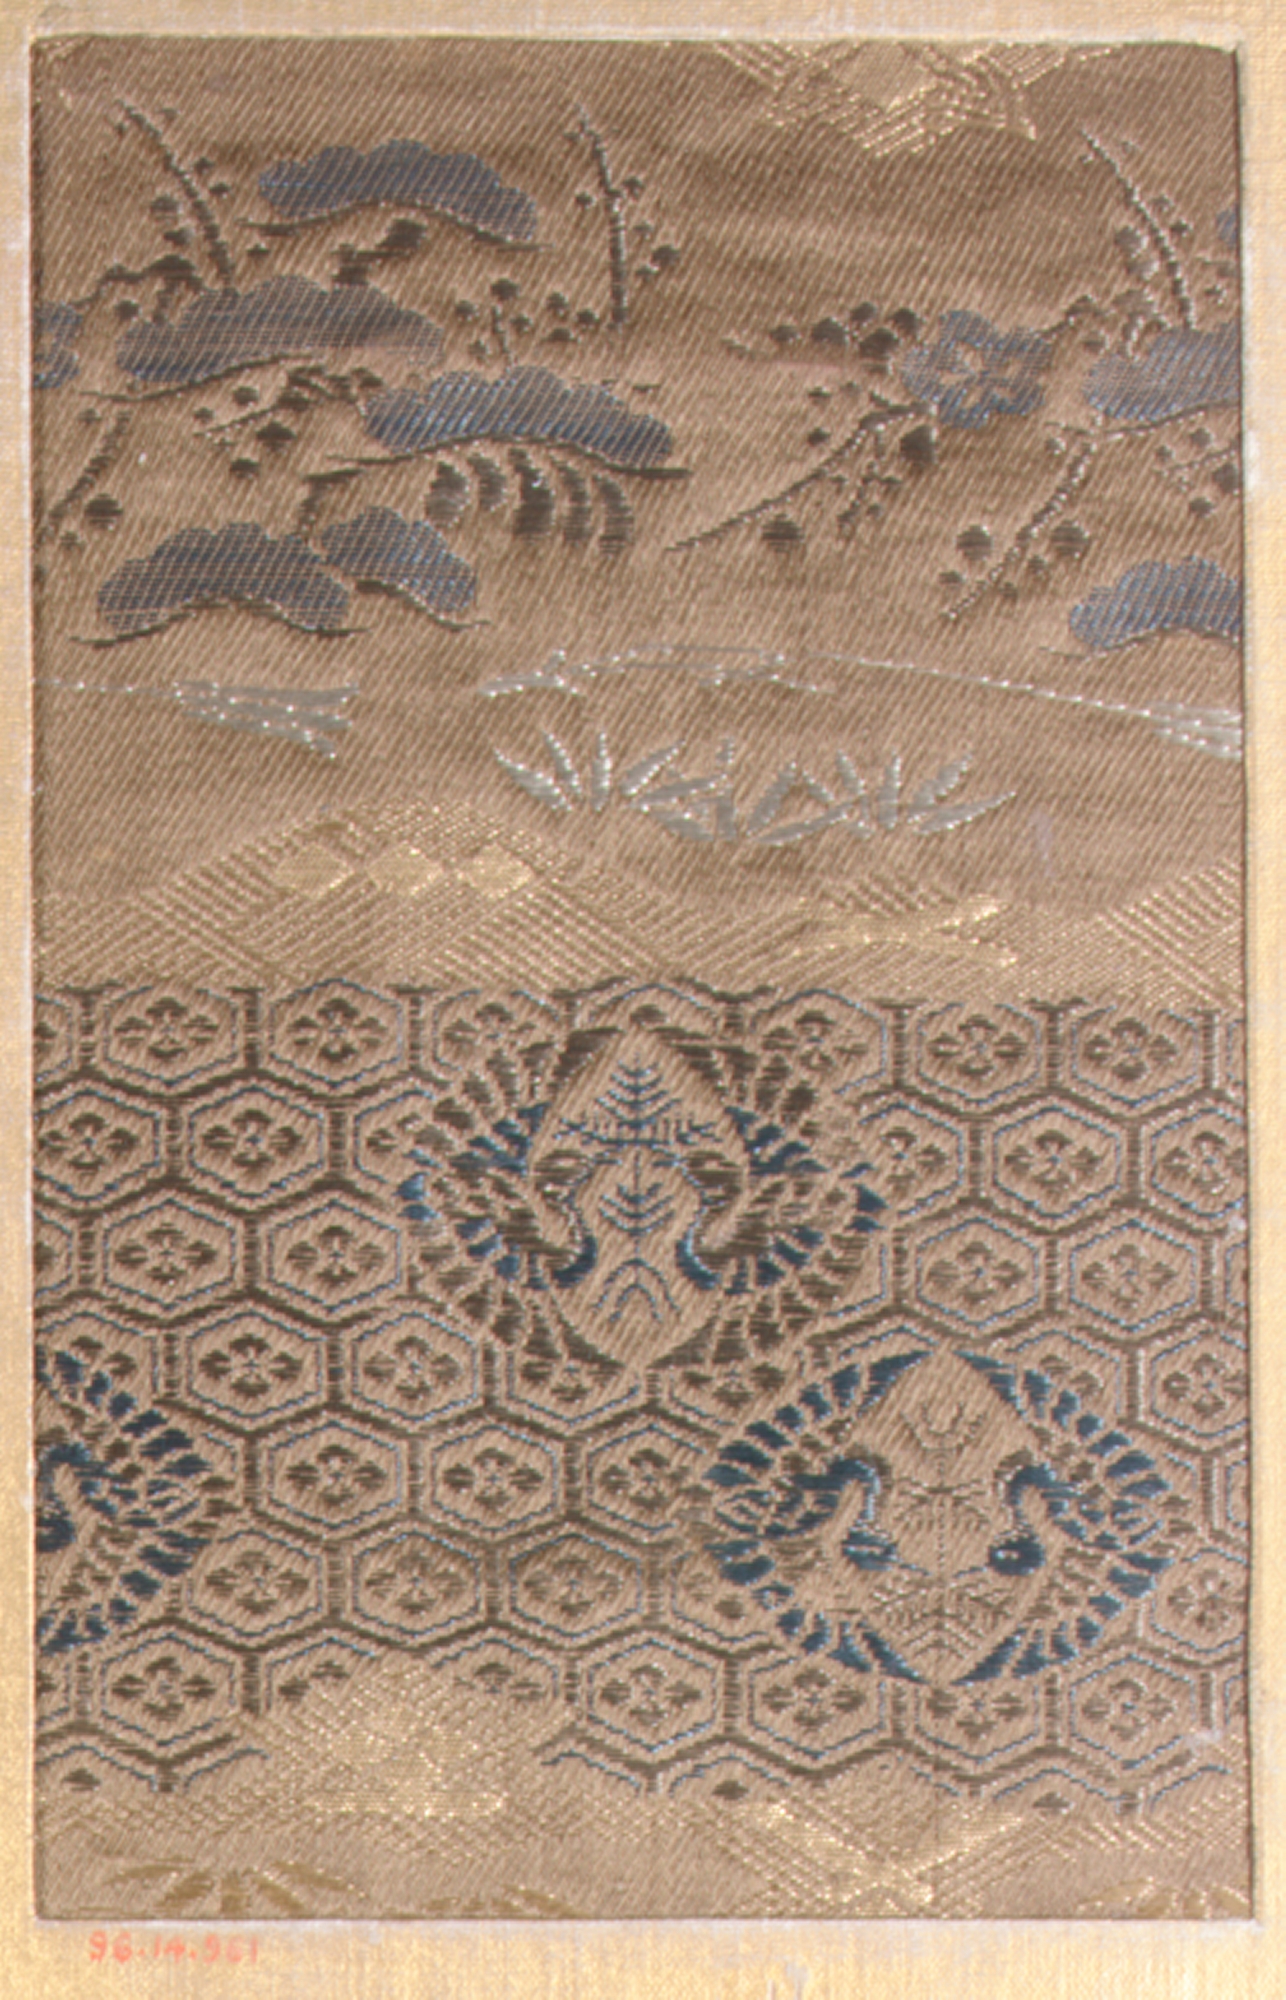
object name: piece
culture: japanese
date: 1701-1900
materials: silk